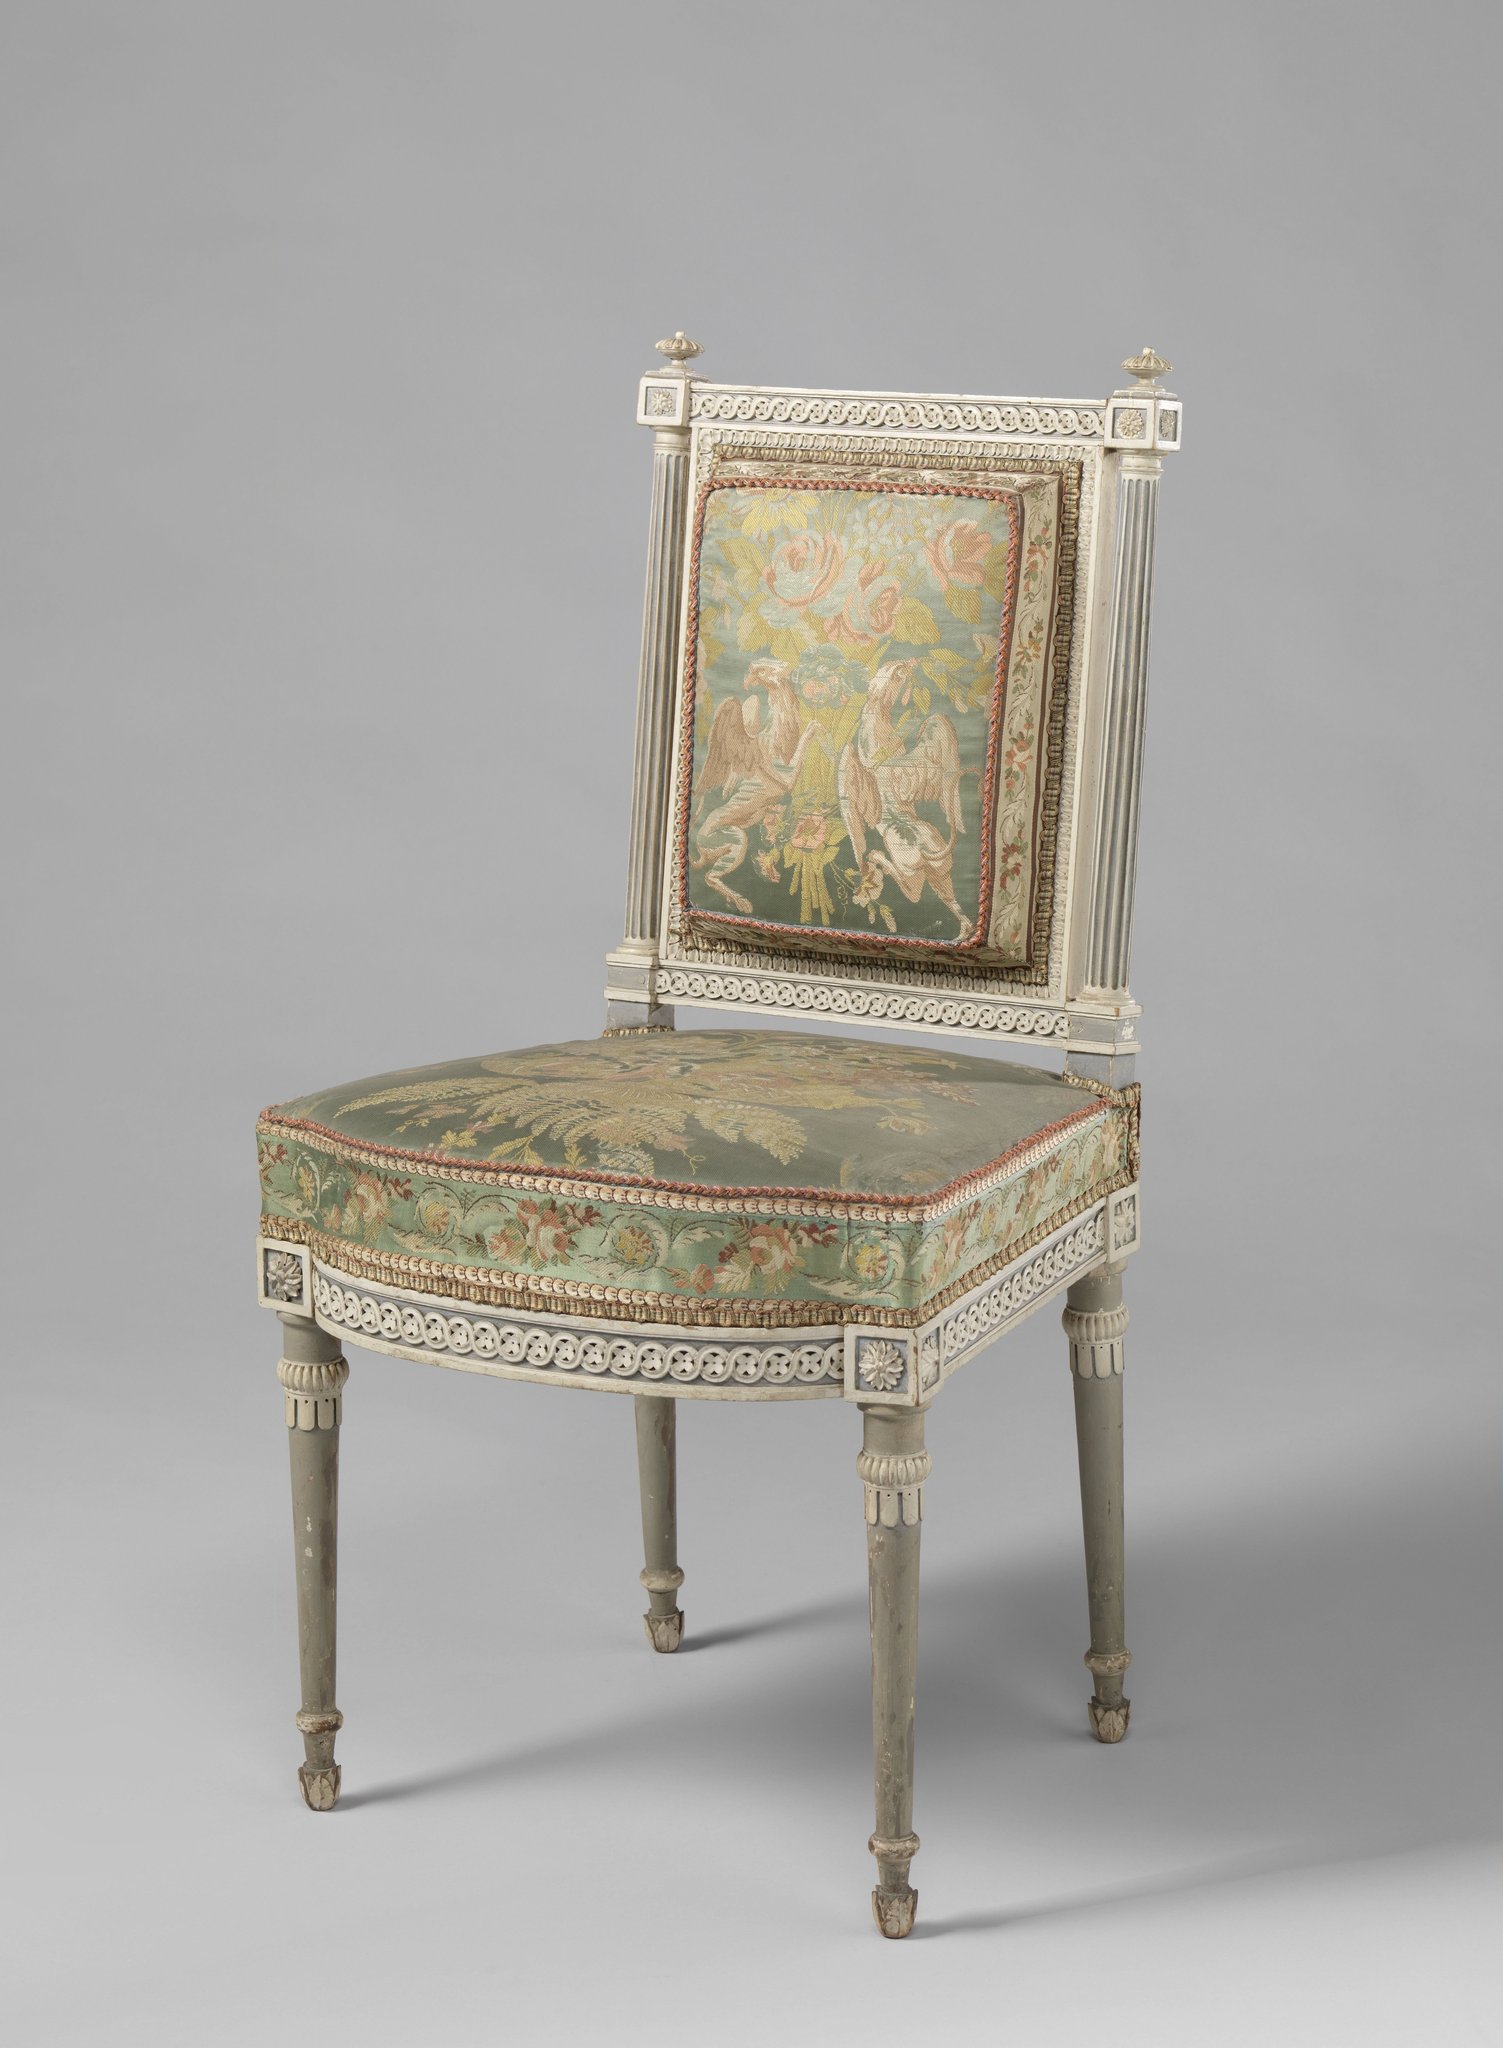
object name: suite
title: Stoel Kops-ameublement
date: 1793-1795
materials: wood, paint, silk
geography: amsterdam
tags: haarlem, griffin (lion/eagle); 'griffo' (ripa), flowers ~ ornament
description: Beklede stoel, deel uitmakend van het Kops-ameublement, van wit en blauwgrijs beschilderd beukenhout en rustend op conische poten. De zitregels en dorpels van het rugraam, met Toscaanse gecanneleerde zuilen als rugstijlen, vertonen gestoken vlechtband met rozetten. Afwerking met rozetten en acanthusbladeren. De bekleding vertoont op lichtblauwe satijnen grond florale motieven, op de rug gehouden door griffioenen. Besteld voor het pand Nieuwe Gracht 74, Haarlem. Zie: BK-15615-a/p, BK-15614, BK-15616-a/b.